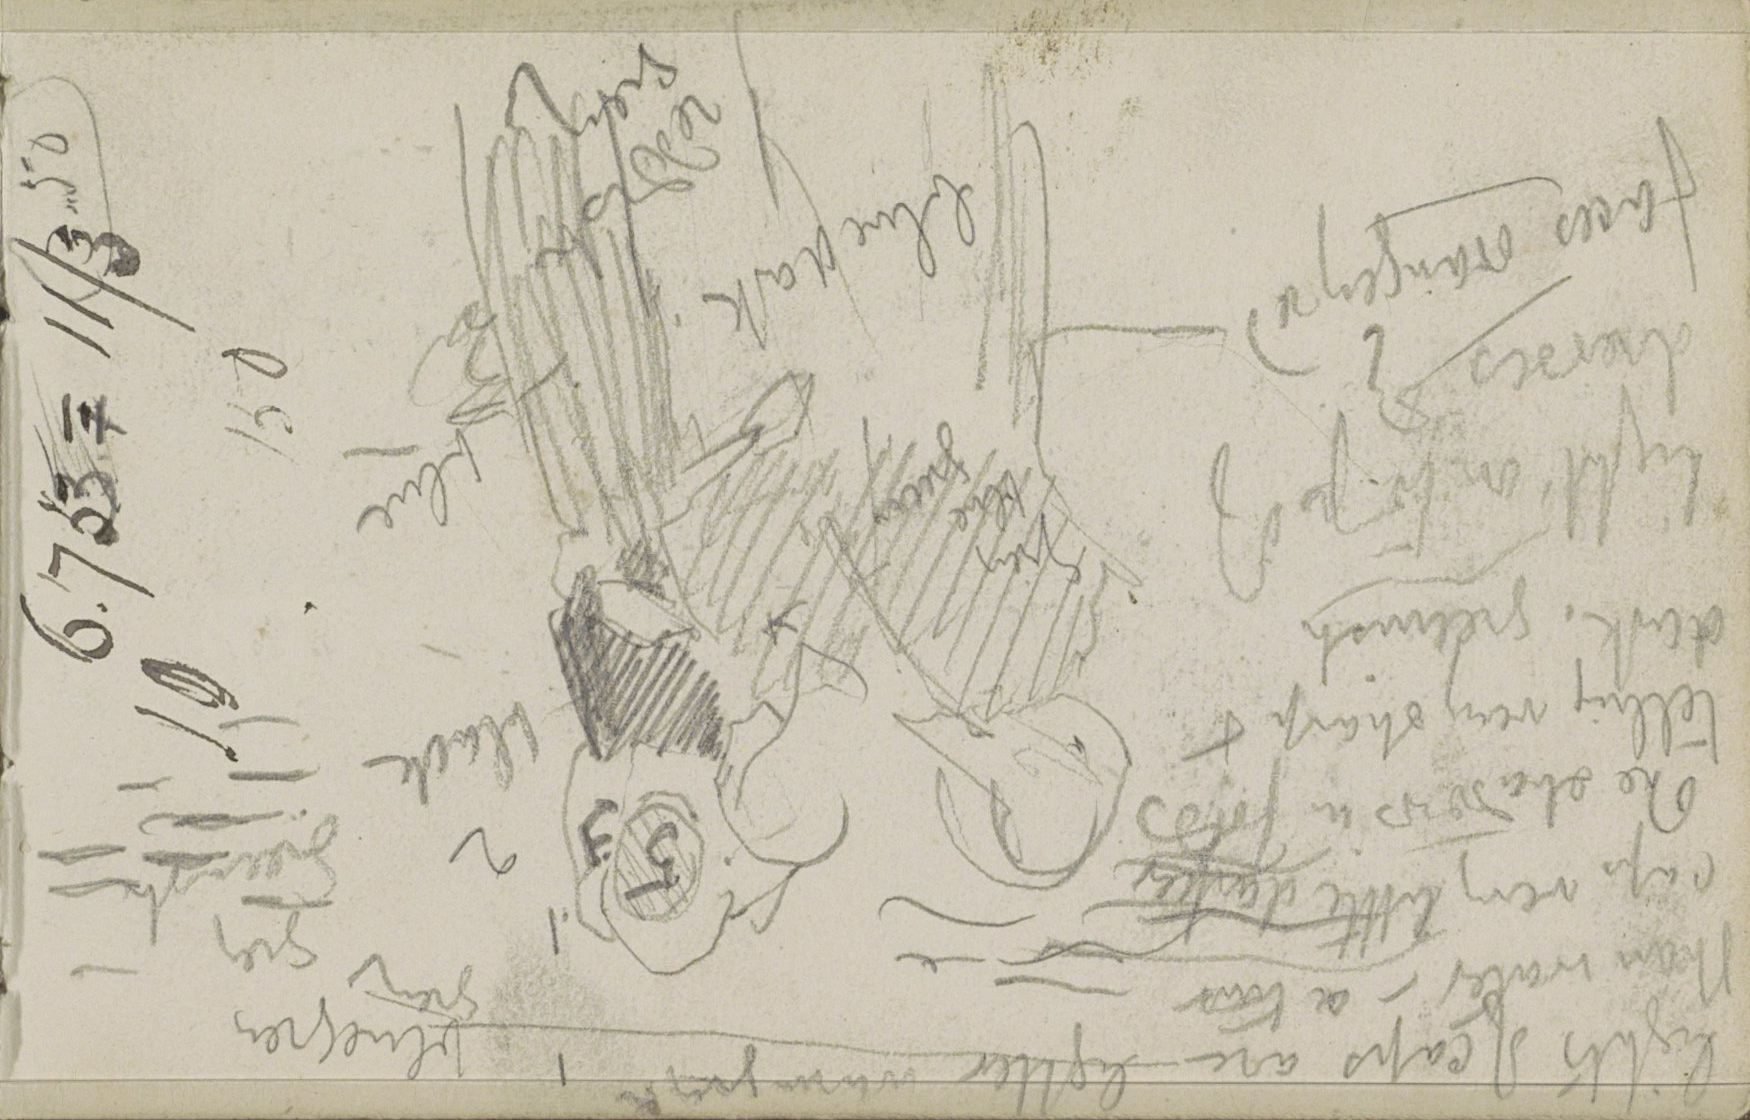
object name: sketchbook leaf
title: Twee vrouwen in klederdracht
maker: george clausen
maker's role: draughtsman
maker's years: 1852-1912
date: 1875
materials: paper, pencil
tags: adult woman, folk costume, regional costume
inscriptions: annotation: ‘6.753.7 11/3/ 10/ 130’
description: Blad 4 recto uit een schetsboek met 38 bladen.